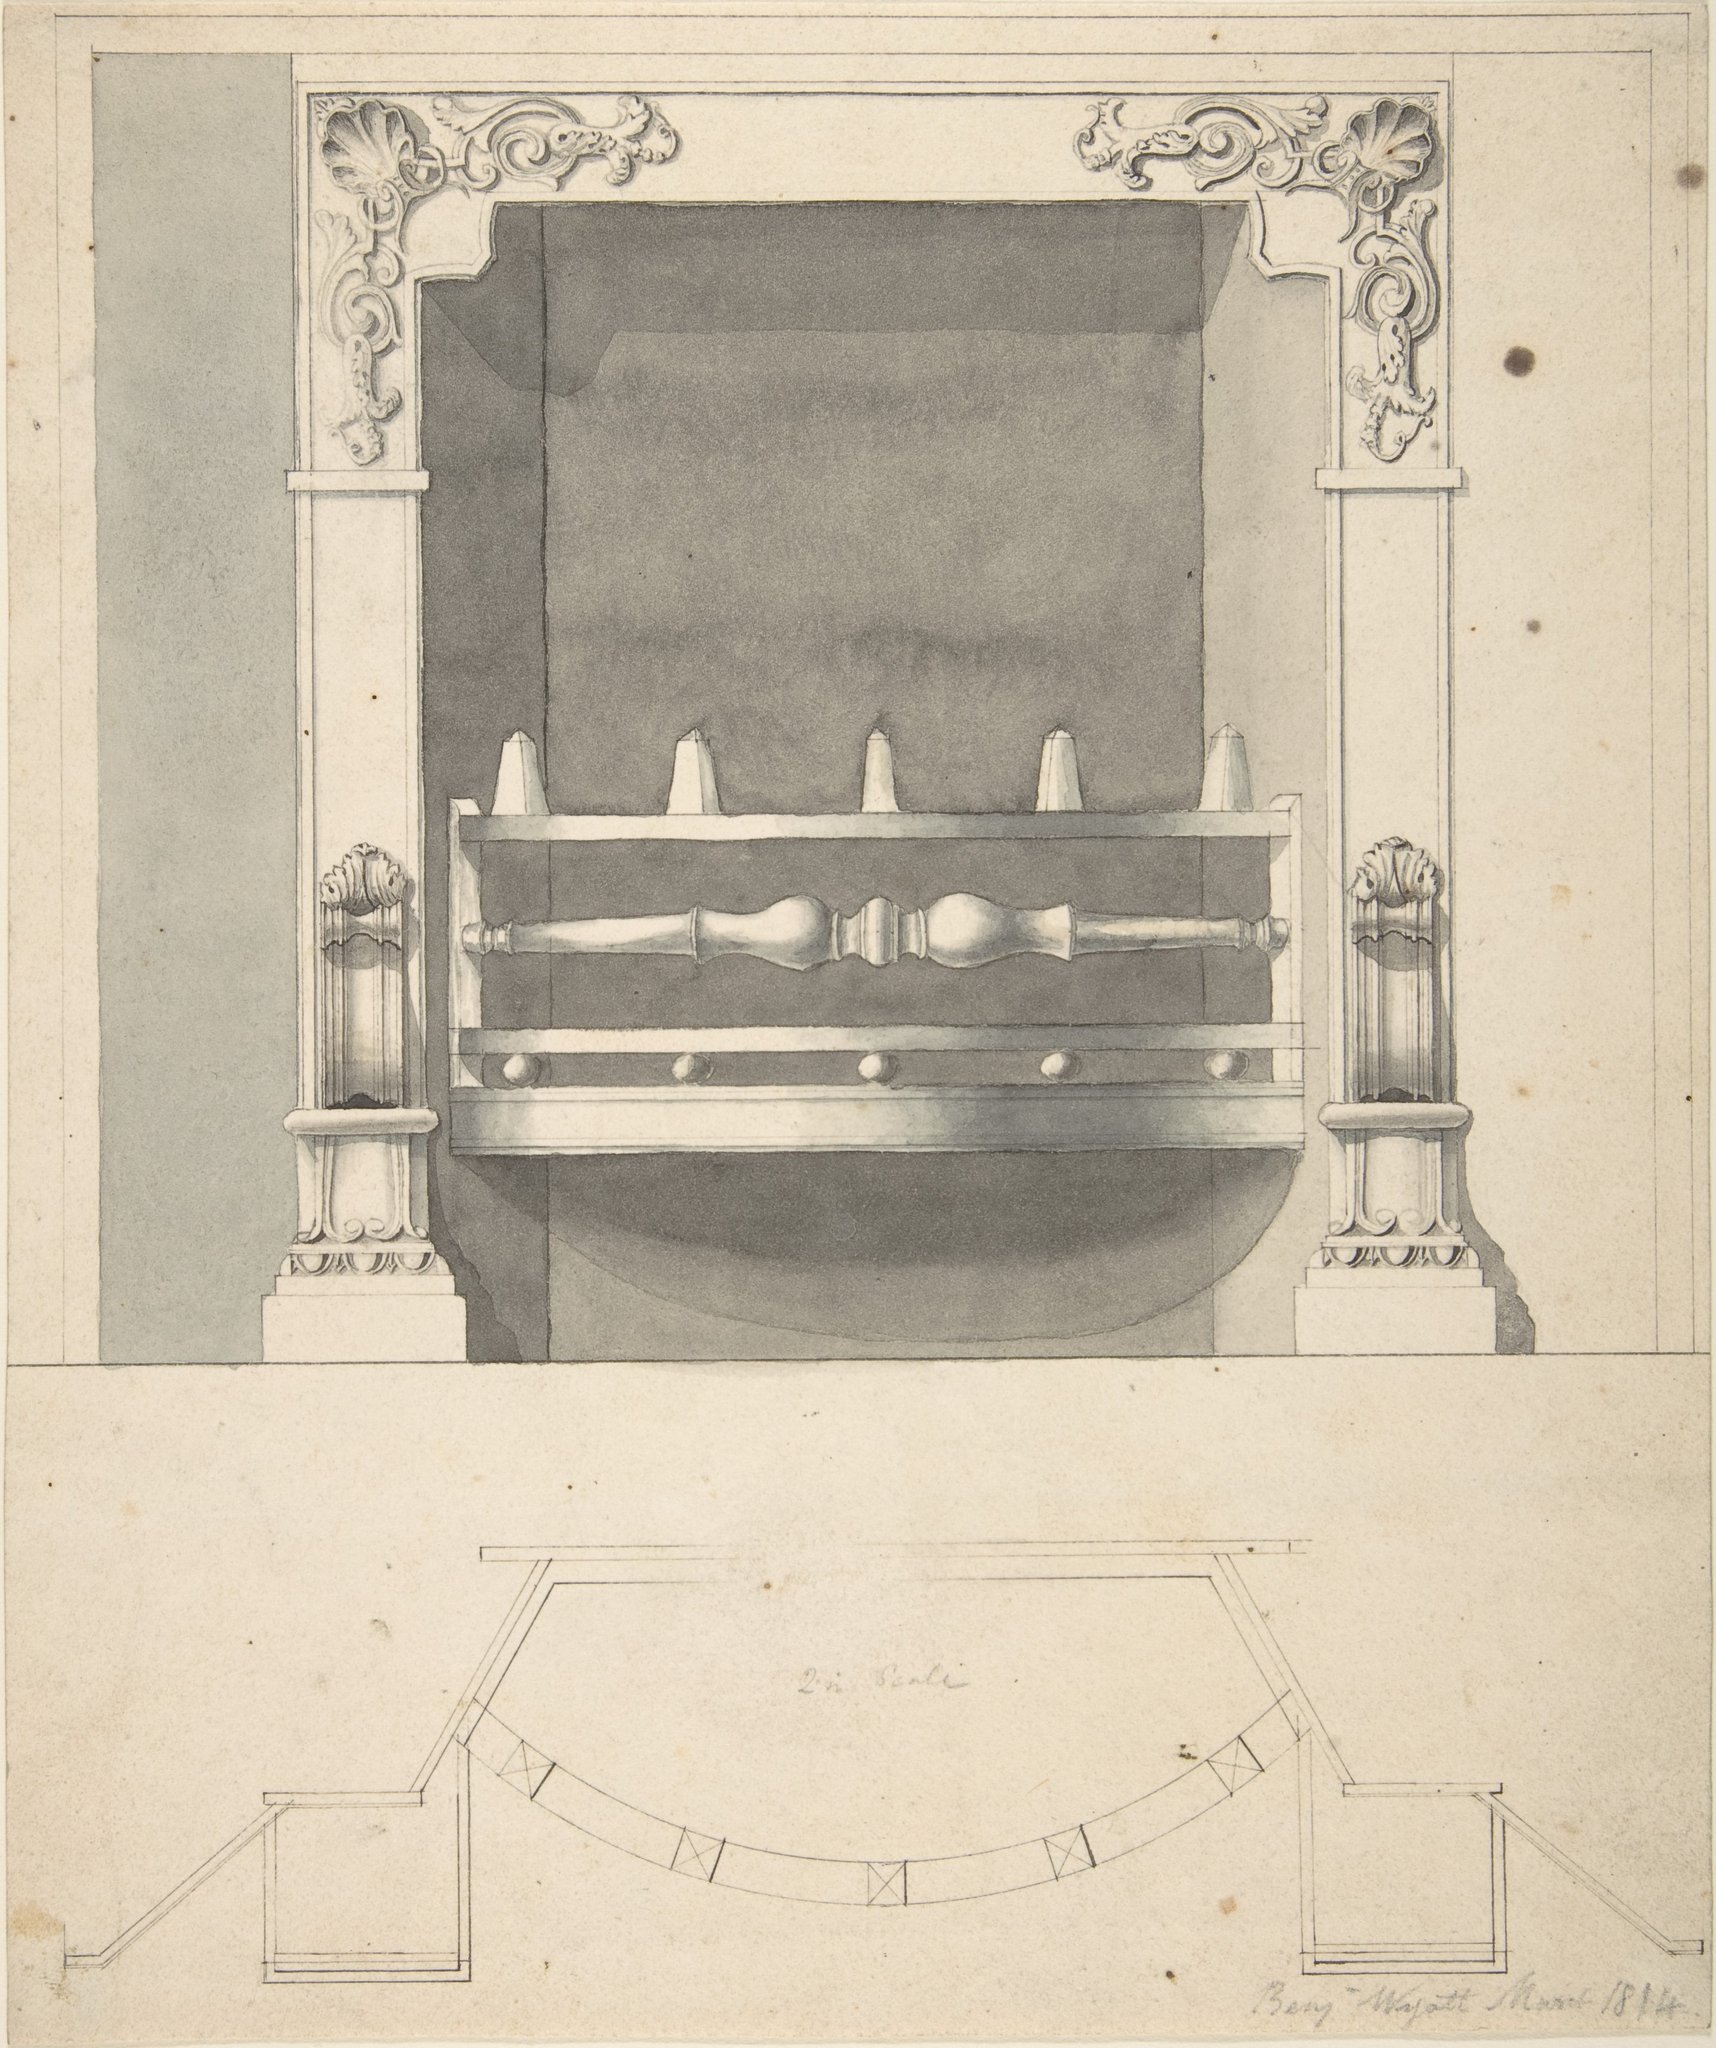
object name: drawing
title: Design for a Cast-iron Hob Grate in Ormolu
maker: benjamin dean wyatt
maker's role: artist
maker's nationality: british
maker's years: 1775-1850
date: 1814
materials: ink, watercolor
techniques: brush, pen, wash